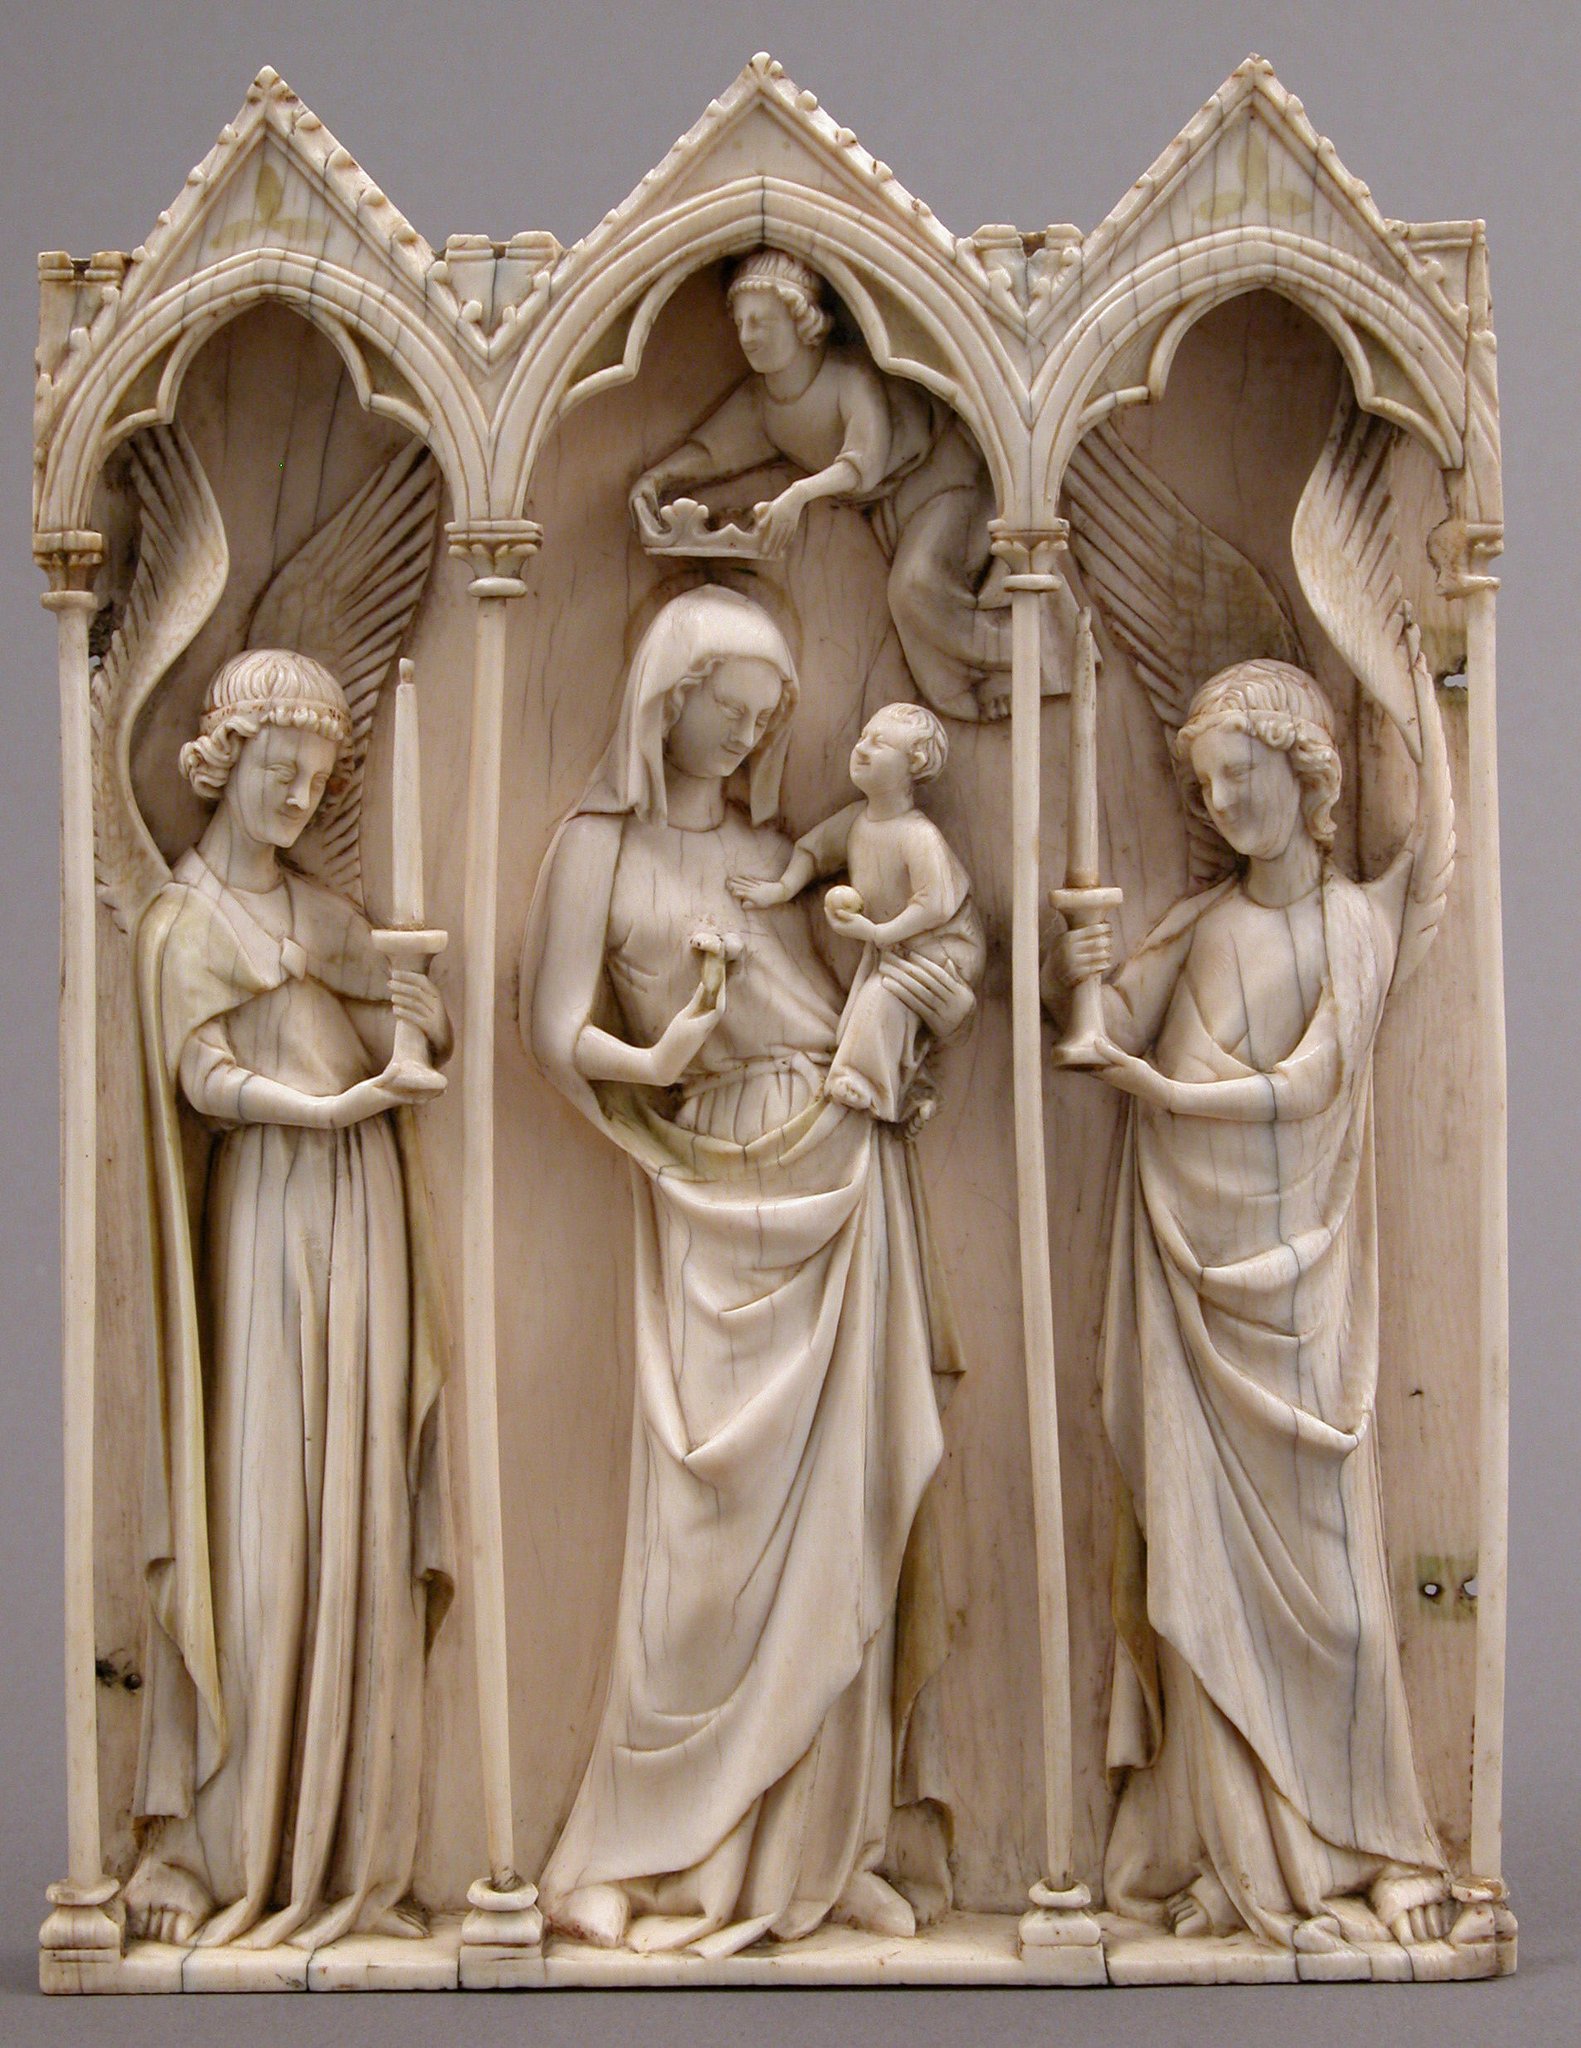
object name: tabernacle or folding shrine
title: Central Portion of a Tabernacle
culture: french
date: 1275-1300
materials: ivory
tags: angels,madonna and child